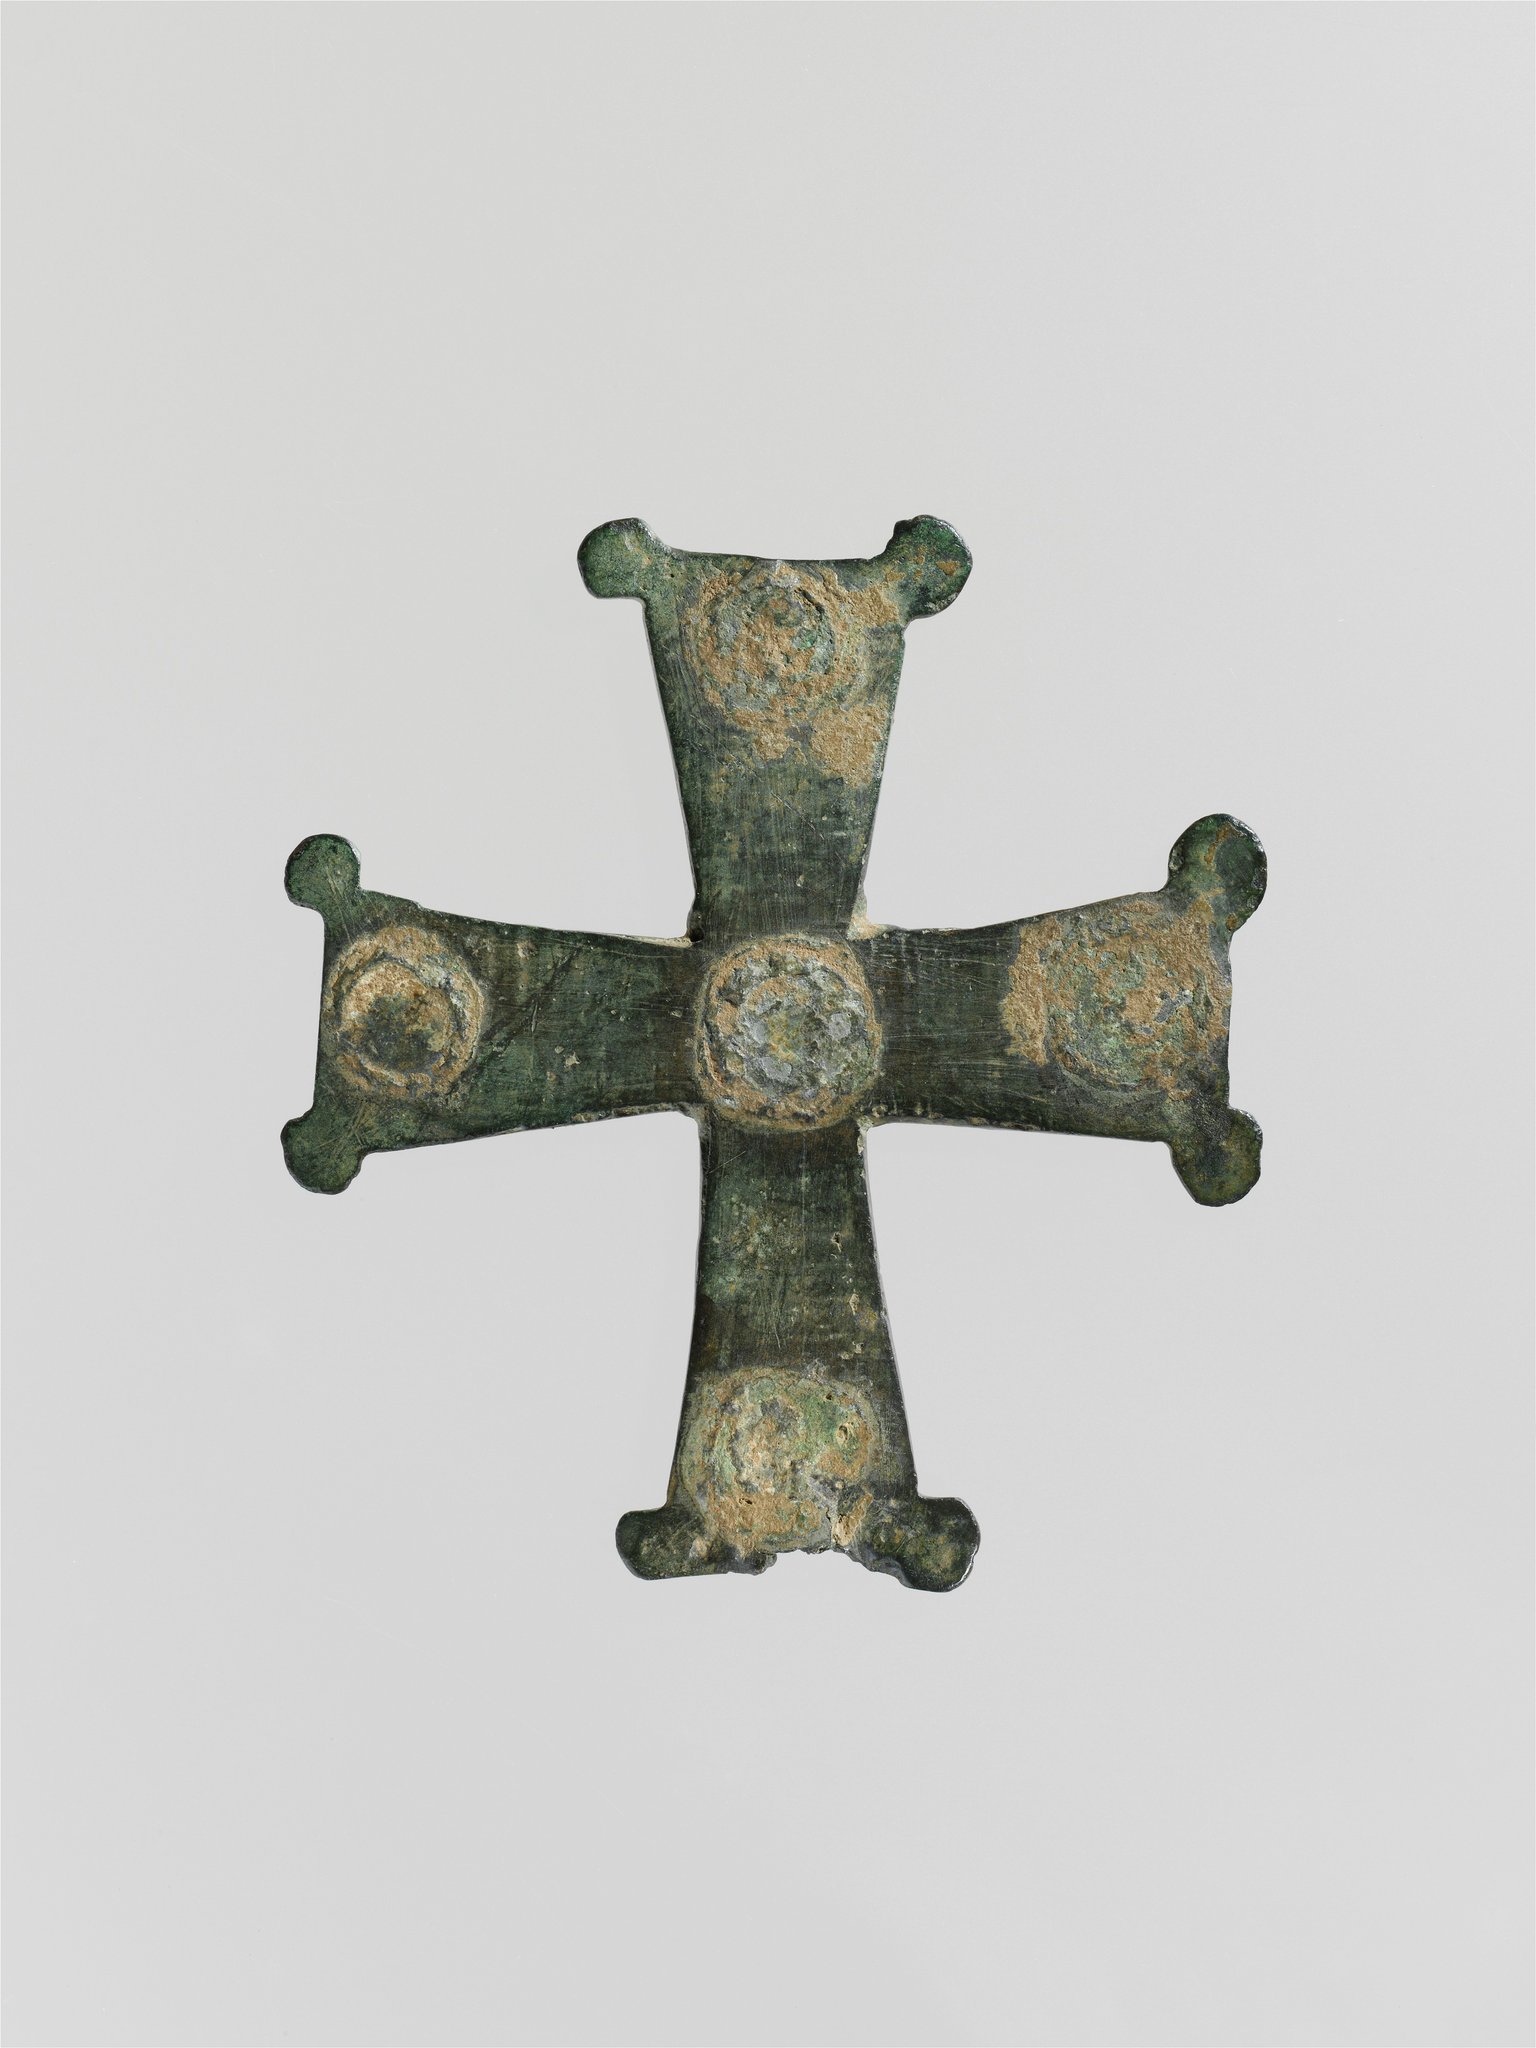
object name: cross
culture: byzantine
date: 801-1200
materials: copper alloy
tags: cross